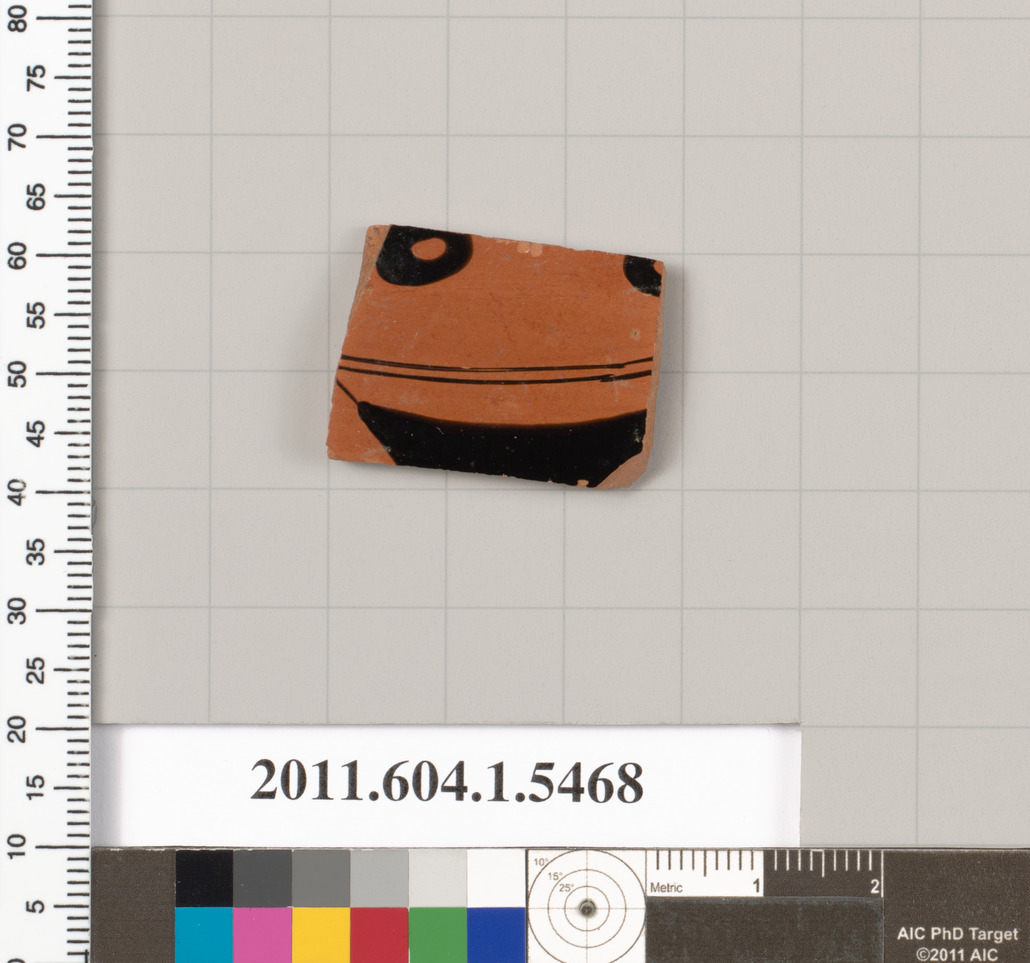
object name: kylix fragment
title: Terracotta fragment of a kylix (drinking cup)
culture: greek, attic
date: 520-500 BCE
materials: terracotta